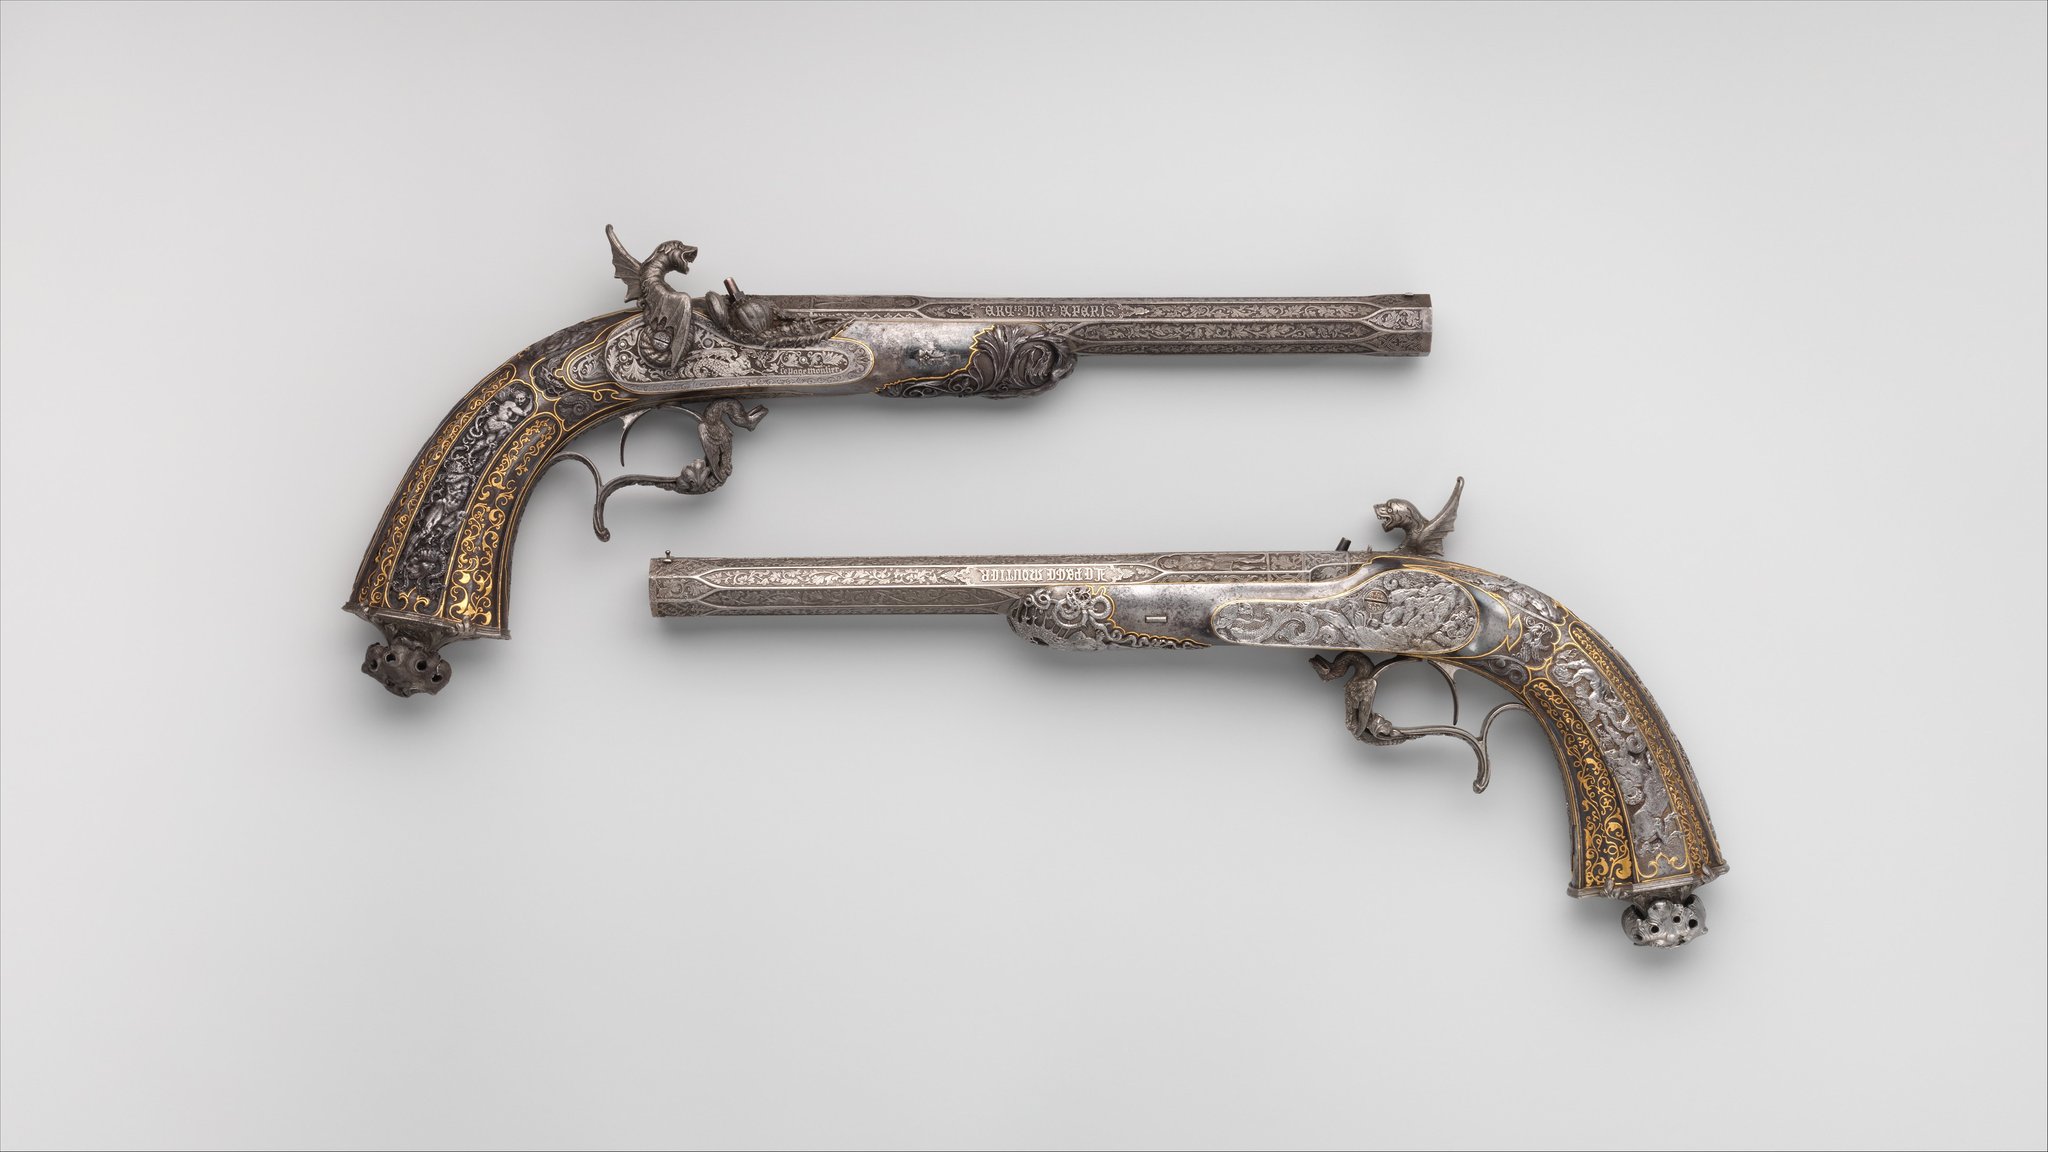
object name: percussion pistol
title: Two Percussion Exhibition Pistols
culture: french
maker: gilles michel louis moutier-le page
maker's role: gunsmith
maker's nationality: french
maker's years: 1842-1865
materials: gold, steel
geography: france